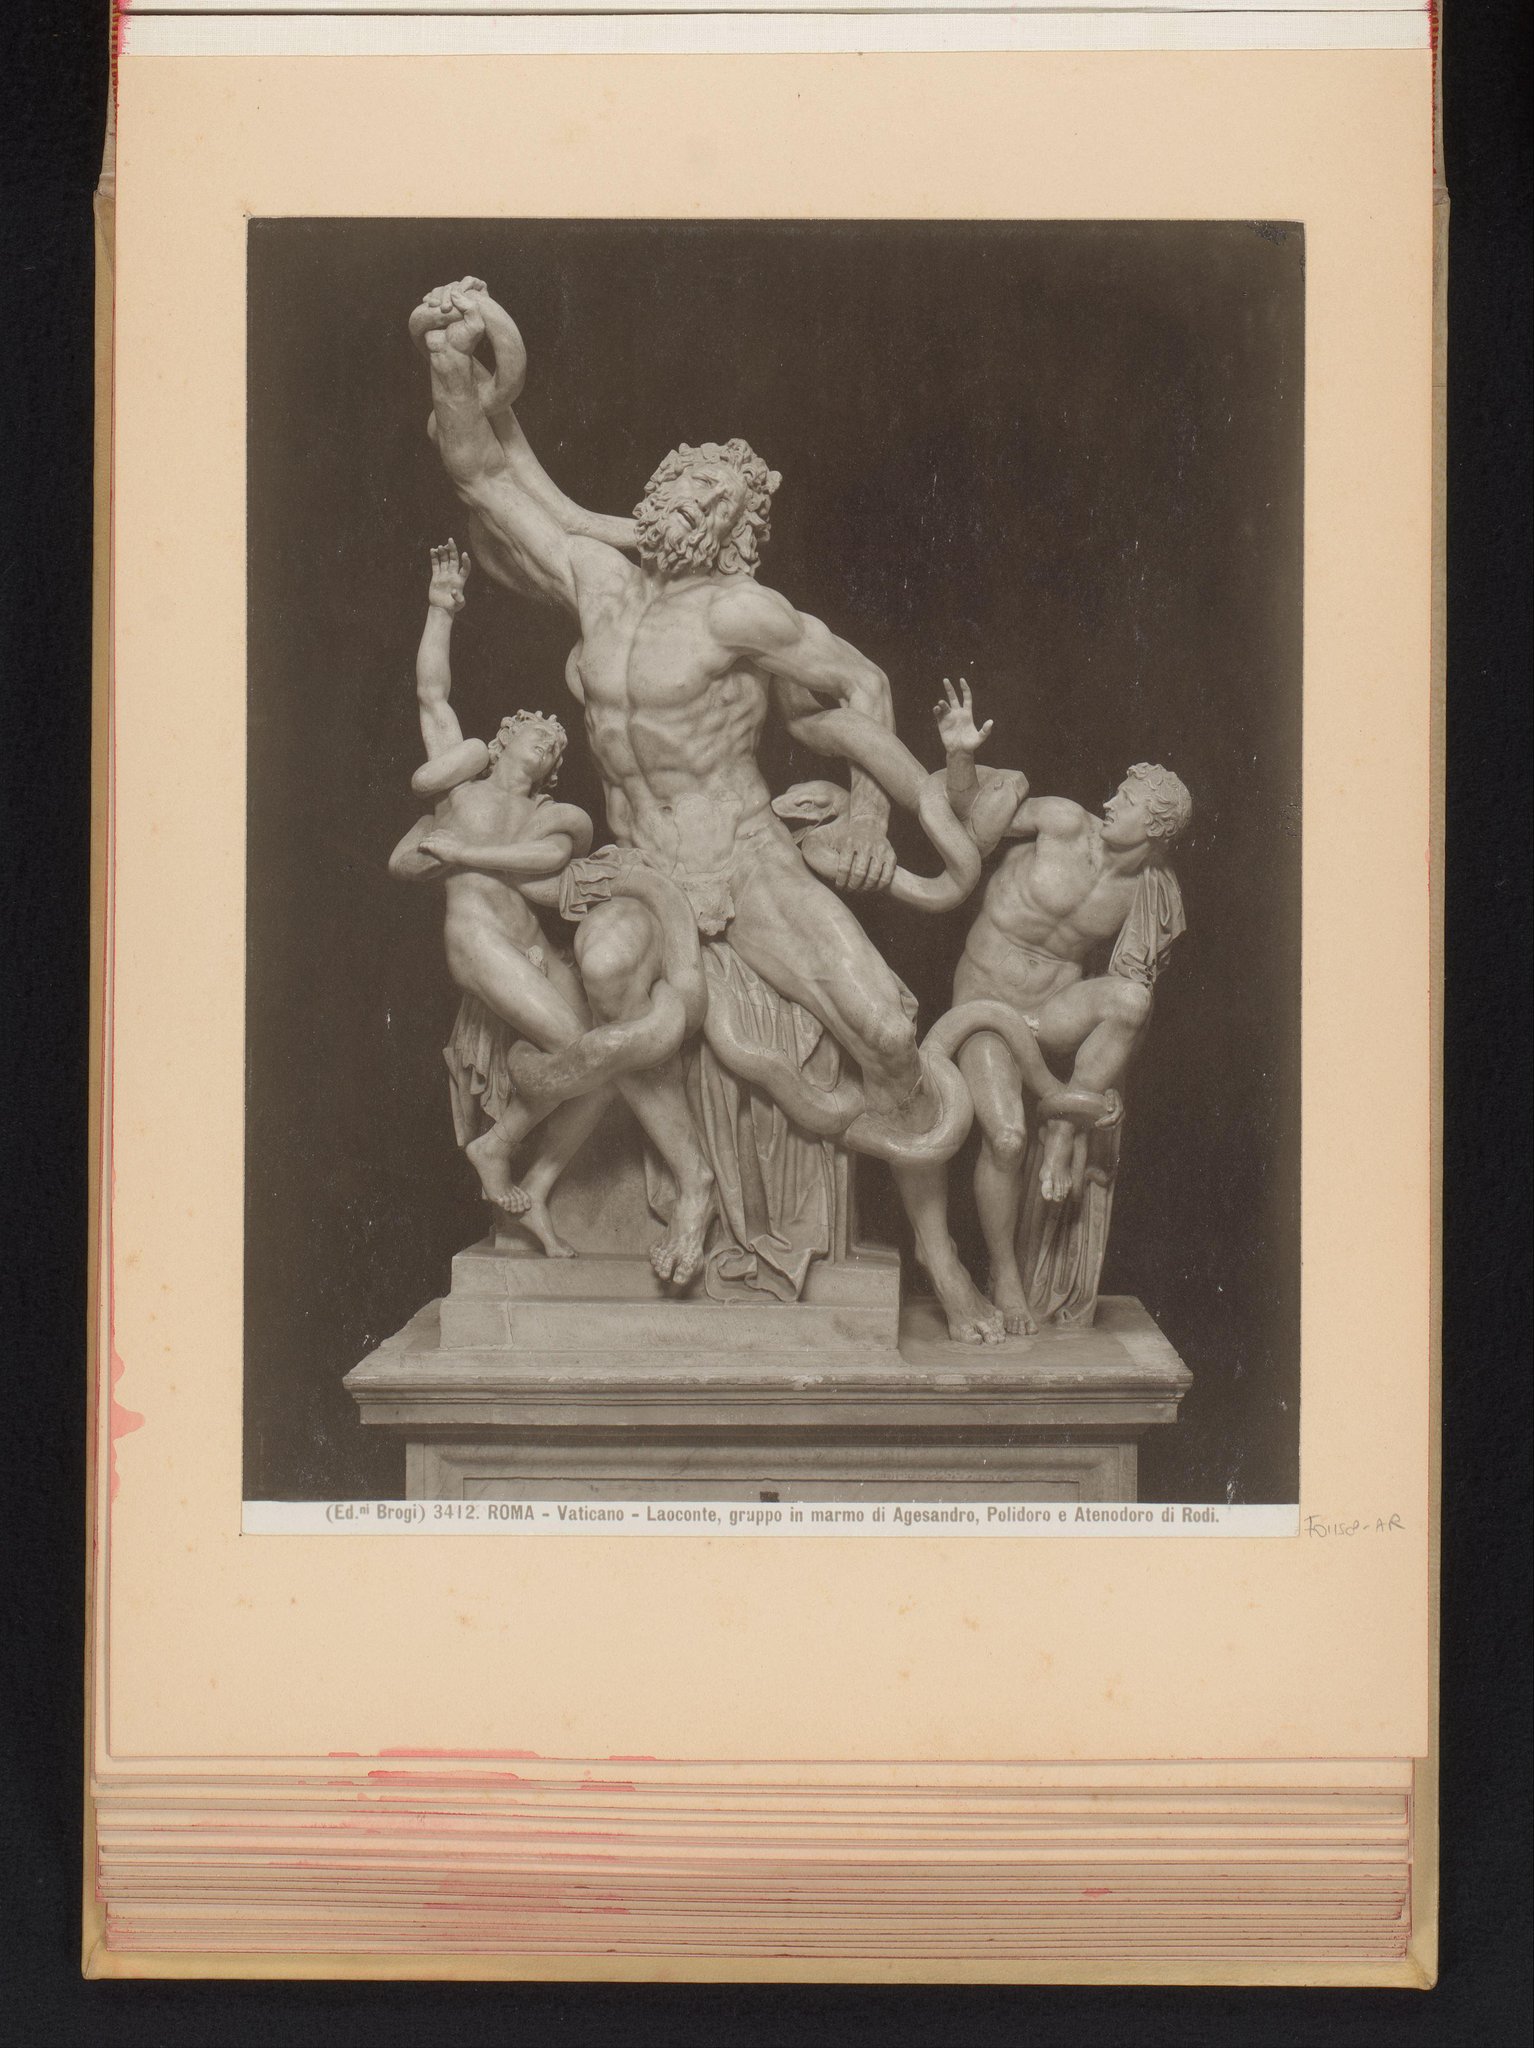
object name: photograph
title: Roma - Vaticano - Laoconte, gruppo in marmo di Agesandro, Polidoro e Atenodoro di Rodi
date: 1875-1907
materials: photographic support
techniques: gelatin silver print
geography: vatican museums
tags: laocoon and his twin sons are strangled by two serpents during the preparations for a sacrifice, sculpture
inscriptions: number: ‘3412’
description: Onderdeel van Fotoalbum met opnames van bezienswaardigheden en kunstwerken in Italië.